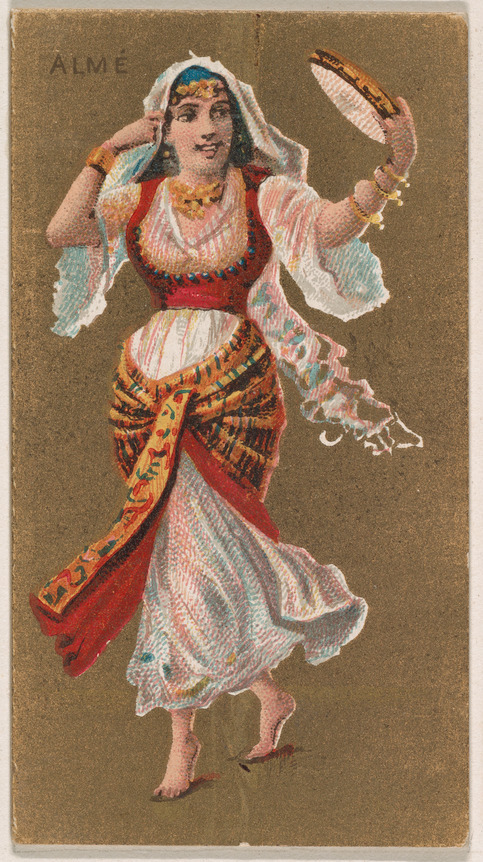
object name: print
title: Alme, from National Dances (N225, Type 2) issued by Kinney Bros.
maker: kinney brothers tobacco company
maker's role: publisher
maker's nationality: american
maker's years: 1869-2011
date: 1889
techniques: color lithograph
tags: women,dancing,dancers